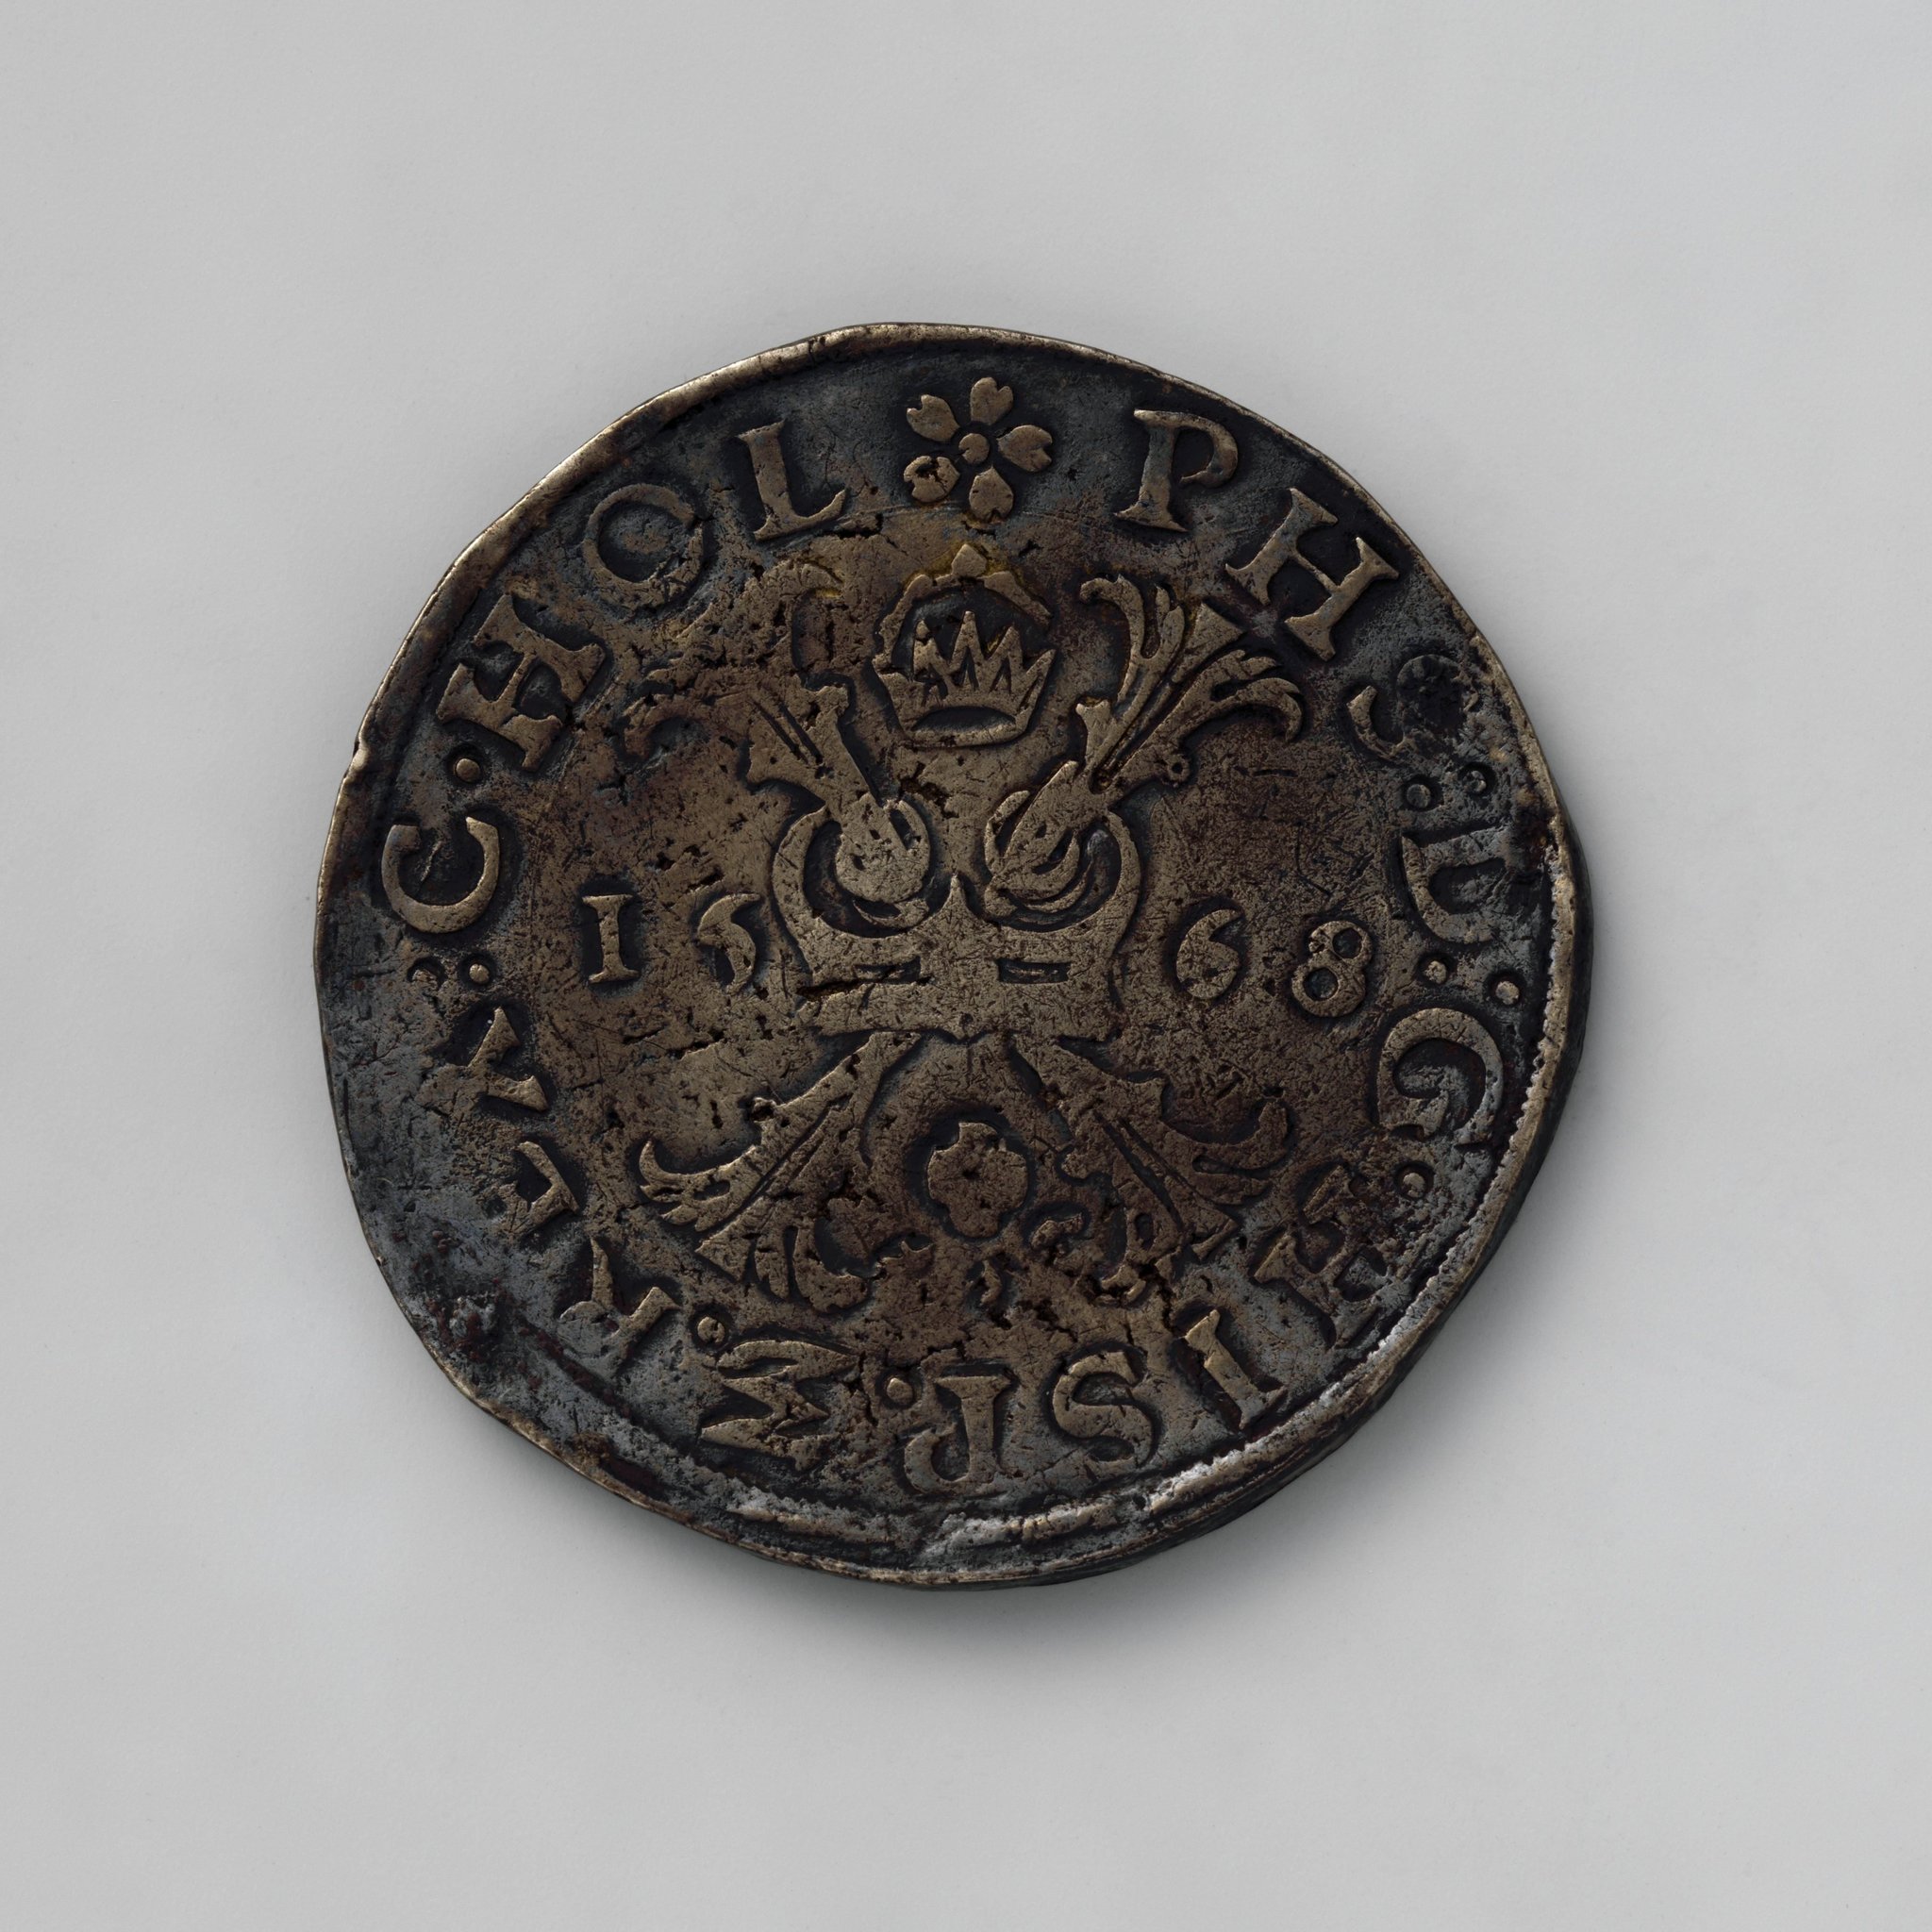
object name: coin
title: Holland, Philips II, bourgondische rijksdaalder, 1568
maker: philip ii of spain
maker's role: koning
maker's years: 1527-1598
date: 1568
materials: silver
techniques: striking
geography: dordrecht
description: Voorzijde: tussen jaartal onder kroon gekruiste knoestige stokken, in het midden vuursteen met vonken. keerzijde: gekroond wapenschild van Bourgondië, omhangen met keten van het Gulden Vlies.